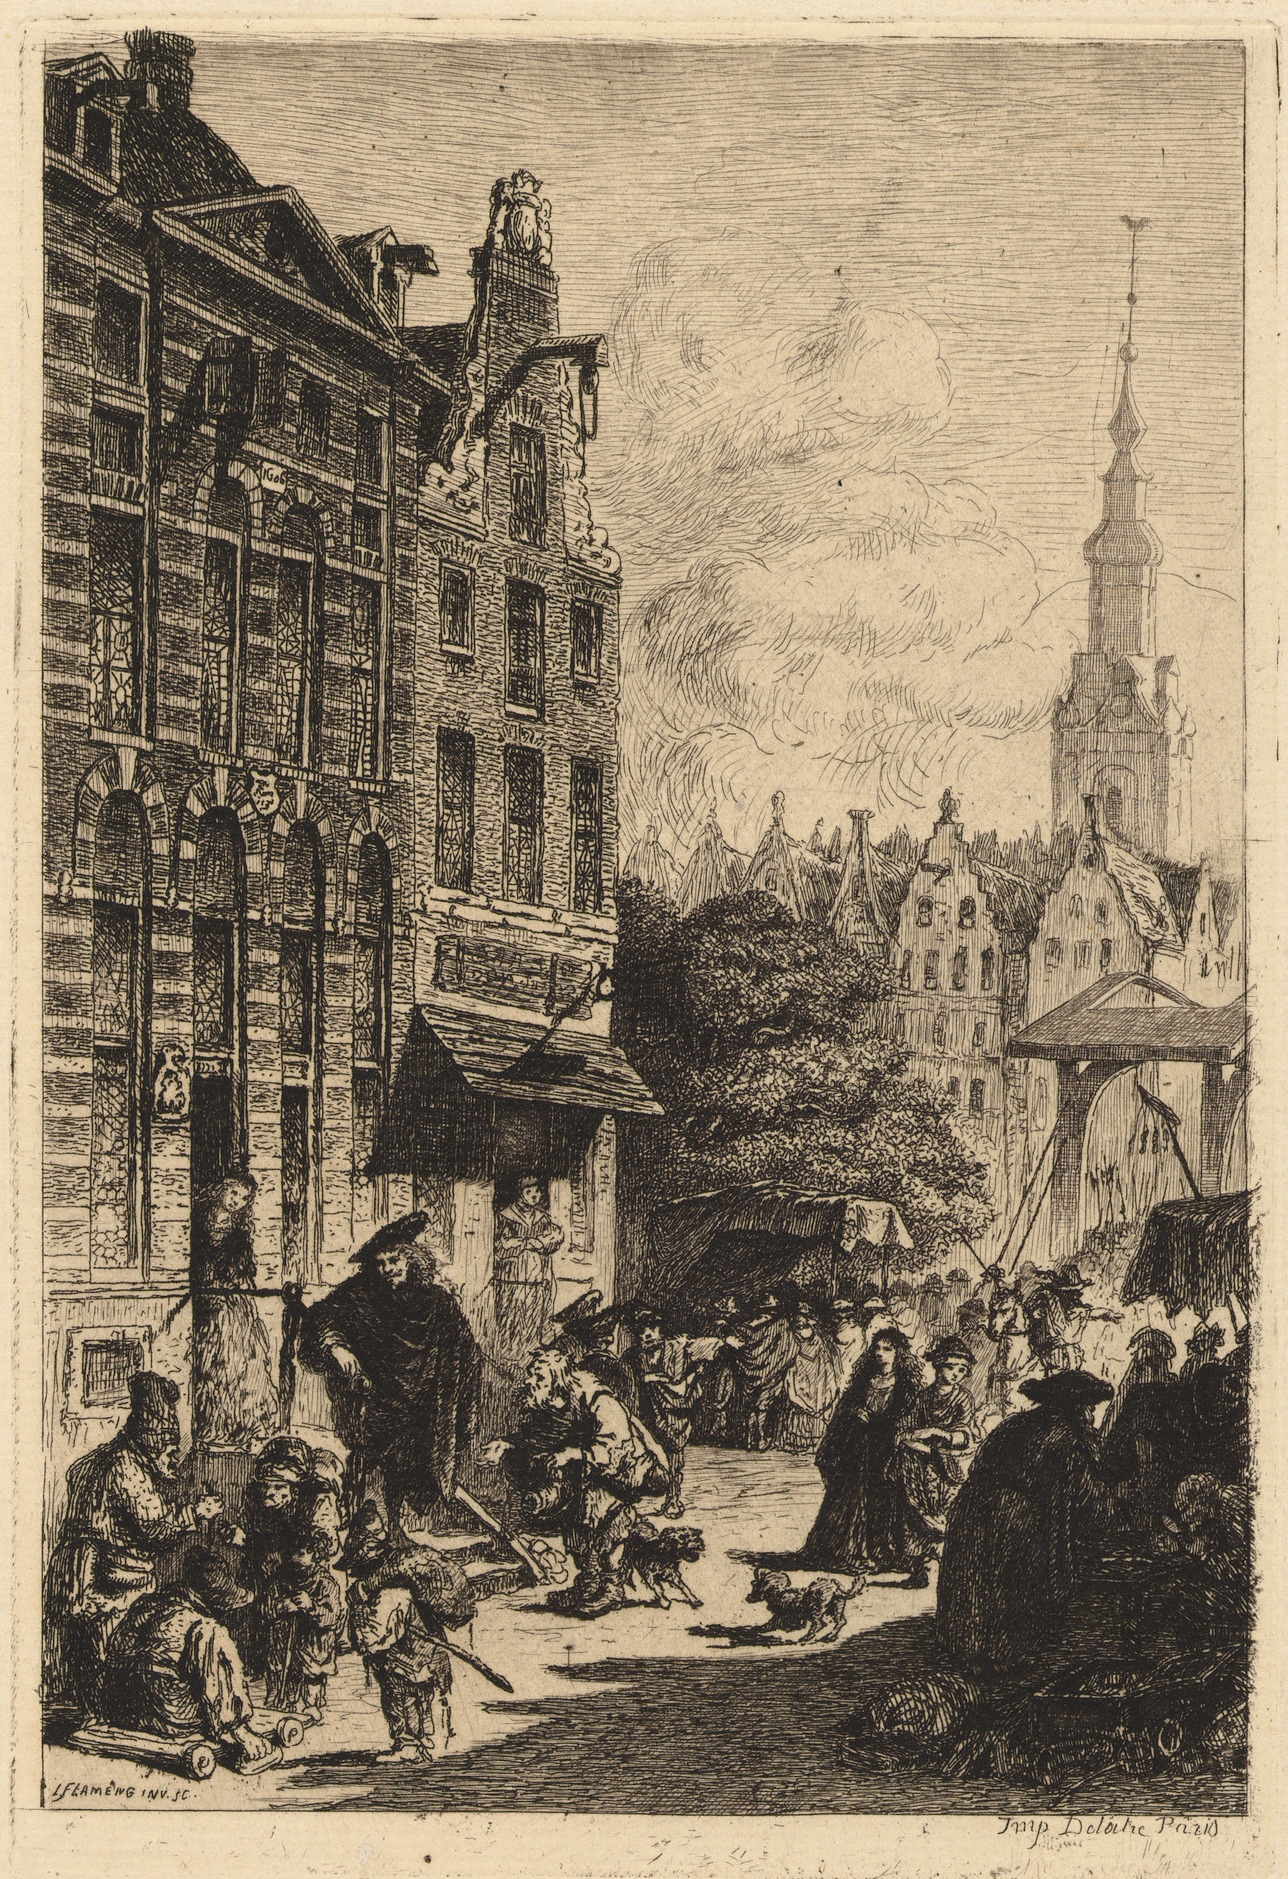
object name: print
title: Rembrandt's House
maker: léopold flameng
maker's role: engraver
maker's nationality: french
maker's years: 1831-1911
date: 1859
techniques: etching